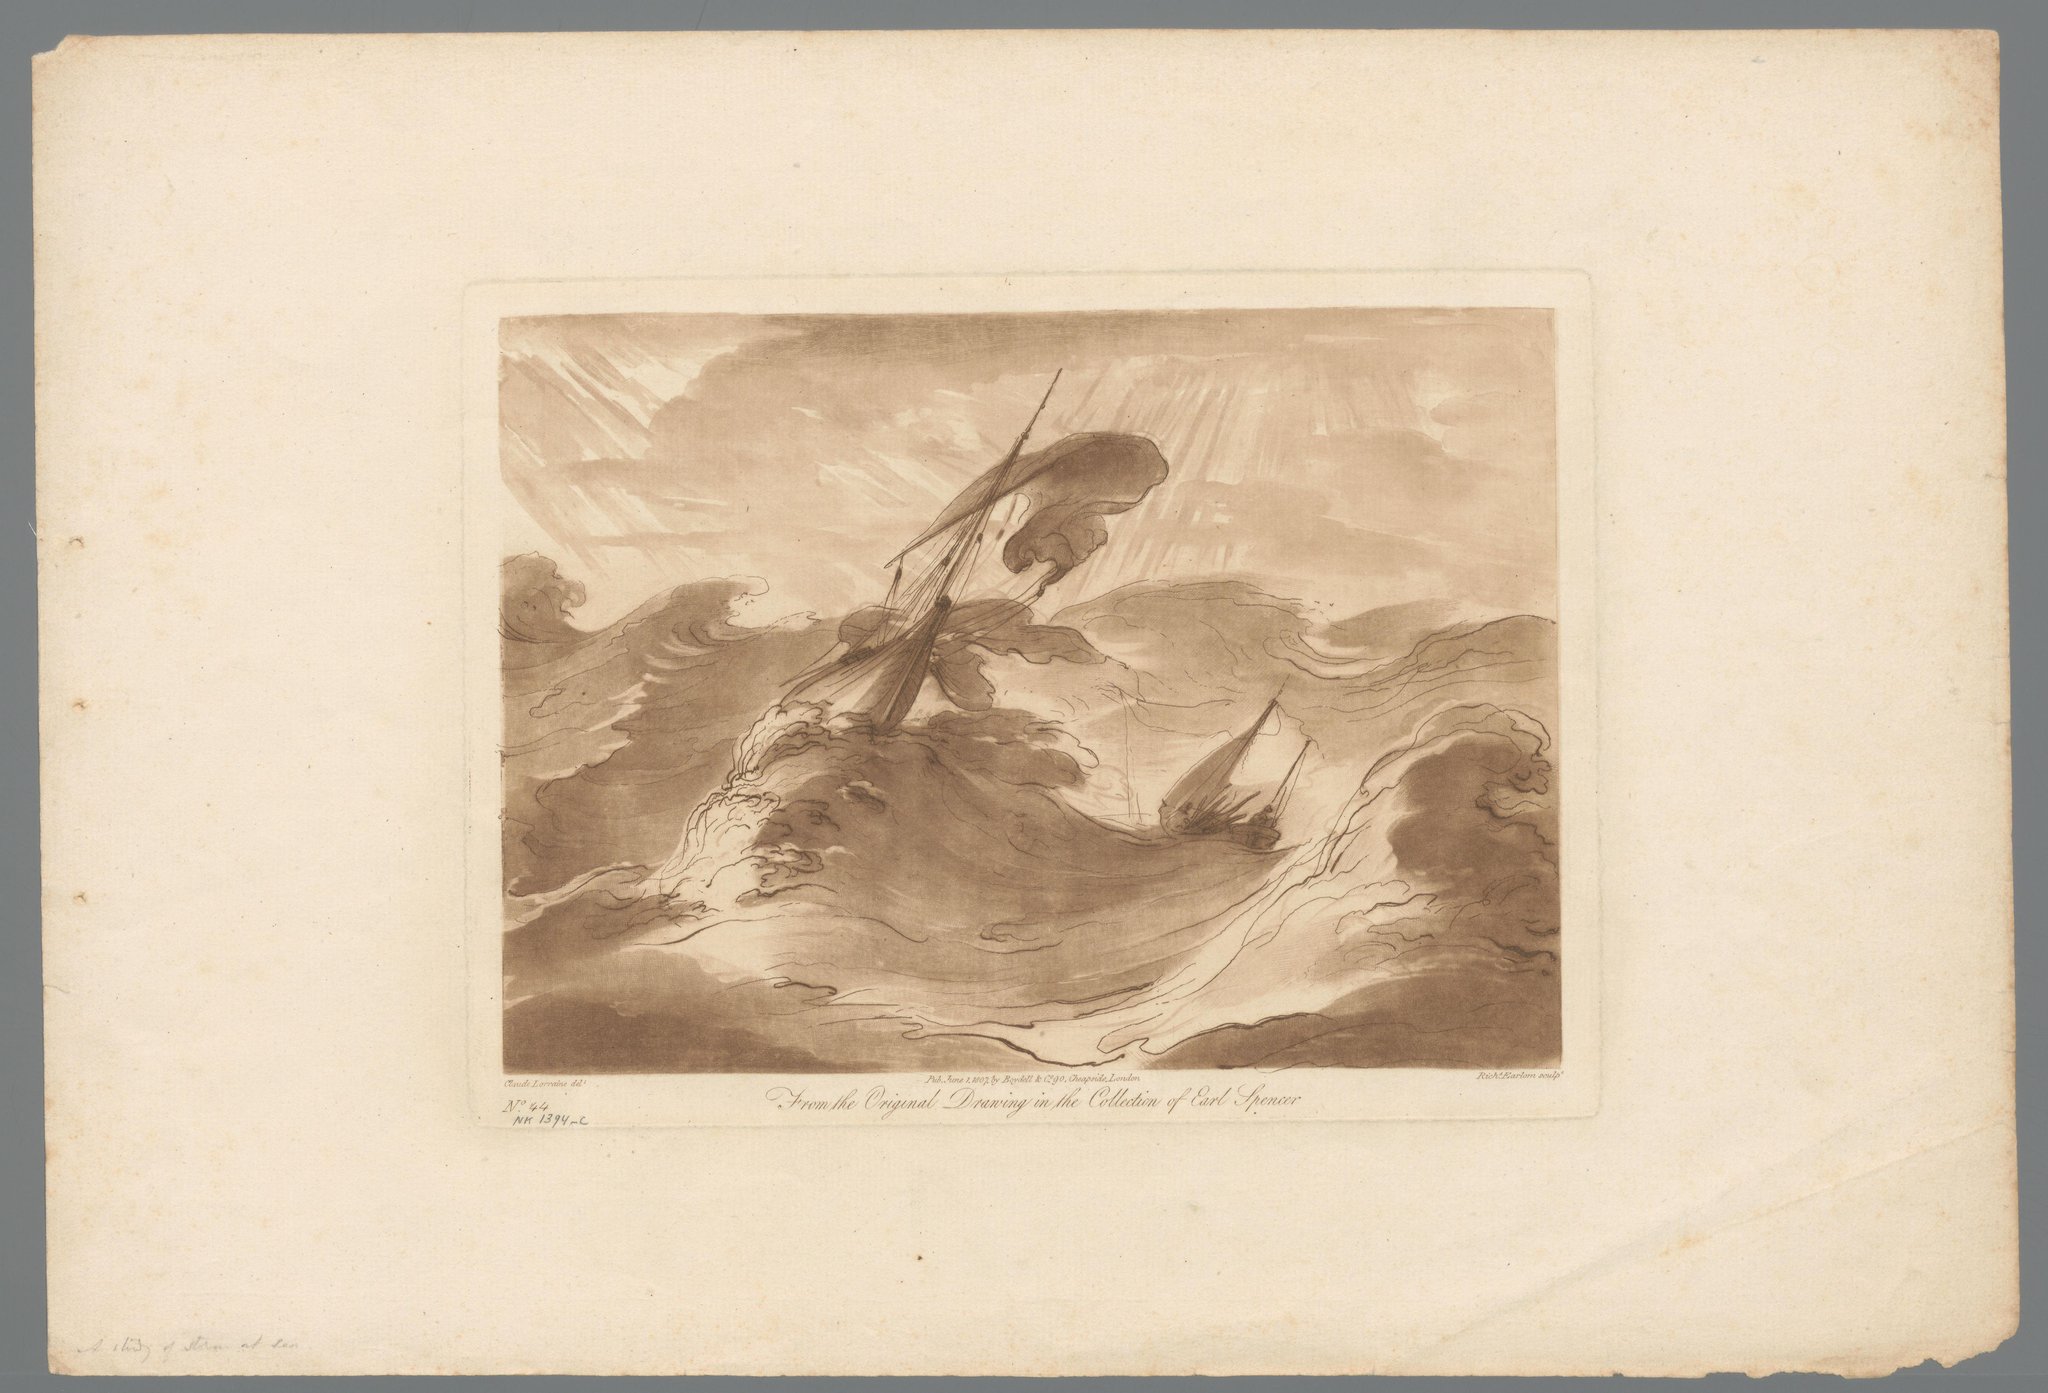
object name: print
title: Prenten naar tekeningen van Claude Lorrain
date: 1807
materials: paper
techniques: aquatint, etching, roulette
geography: england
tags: sailing-ship, sailing-boat, storm at sea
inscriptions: stamp: ‘foto’, collector's mark: Lugt 2228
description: De prent werd in 1819 nogmaals gebonden uitgegeven: Earlom, Richard. Liber Veritatis; or A Collection of Prints, after the Original Designs of Claude le Lorrain (...). Londen: Hurst, Robinson & Co., 1819.